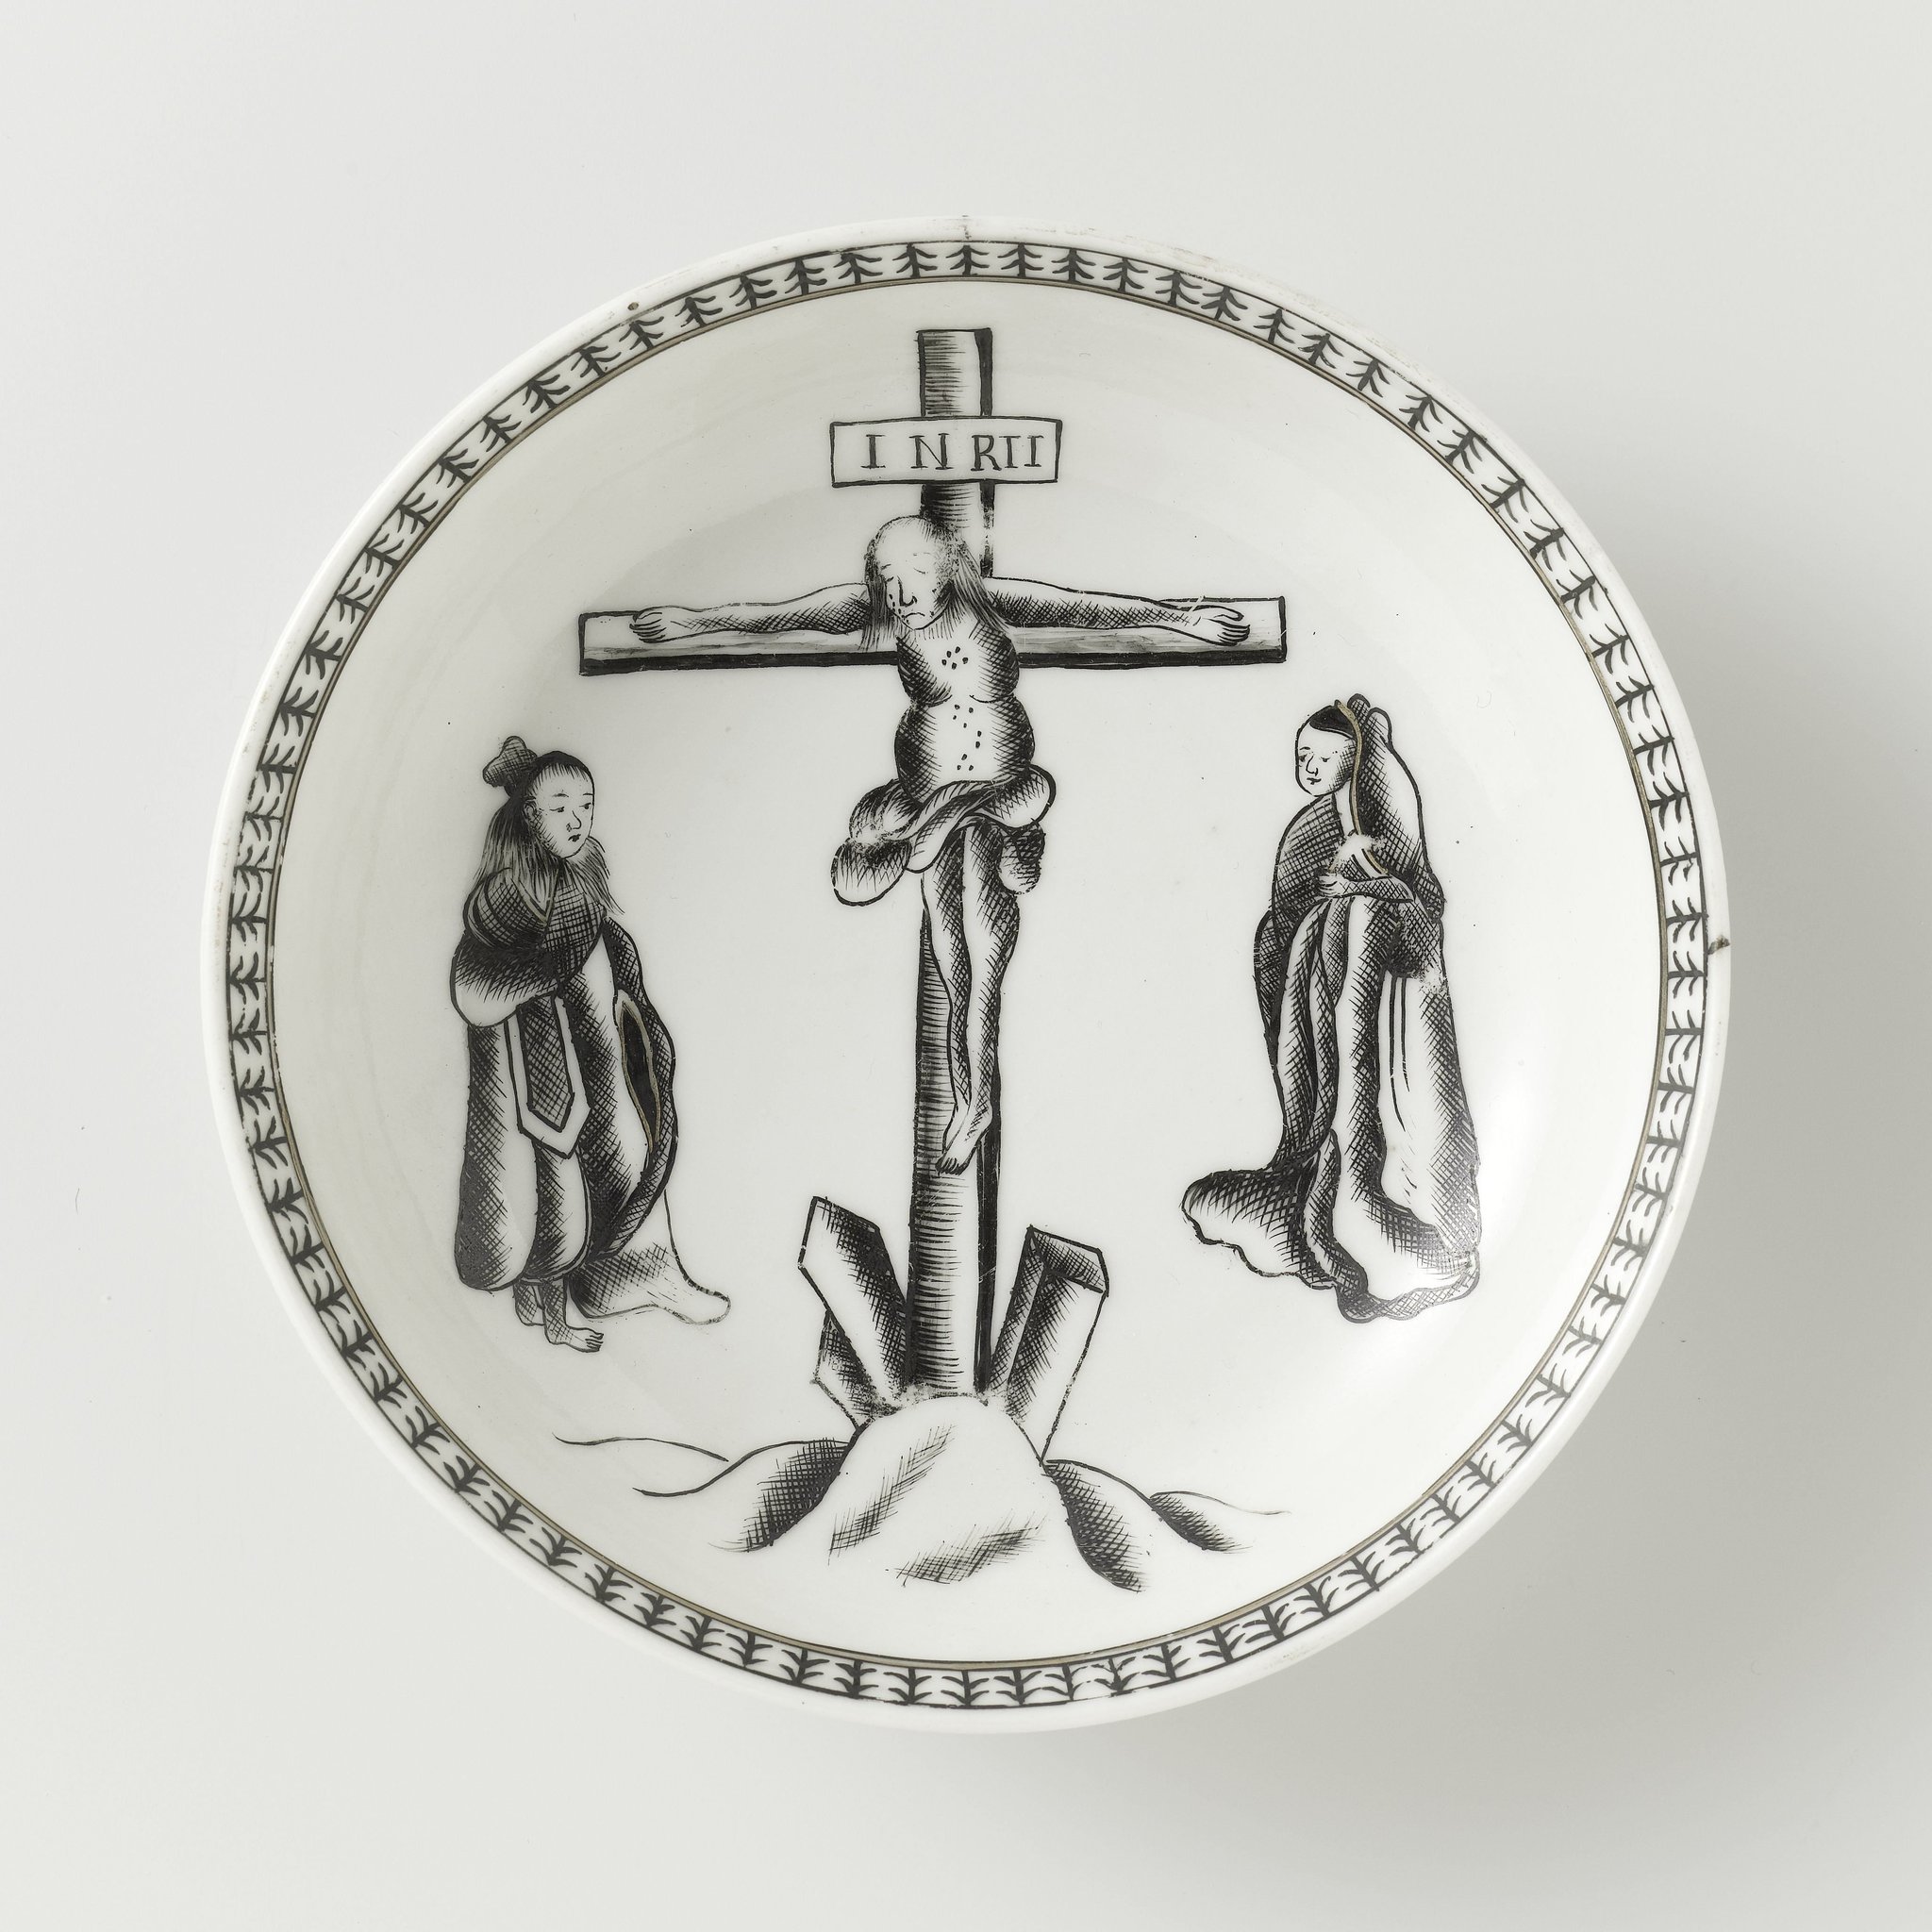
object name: platter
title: Saucer with a crucifixion scene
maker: Anonymous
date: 1780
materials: glaze, gold, paint, porcelain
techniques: firing, gilding, turning, vitrification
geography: china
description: Schotel van porselein, beschilderd op het glazuur in zwart en goud. Op het plat van de schotel een voorstelling van de Kruisiging met de twee Maria's; op de rand een band met een decoratief patroon. Onderdeel van een theeservies. Europese voorstelling in encre de Chine.